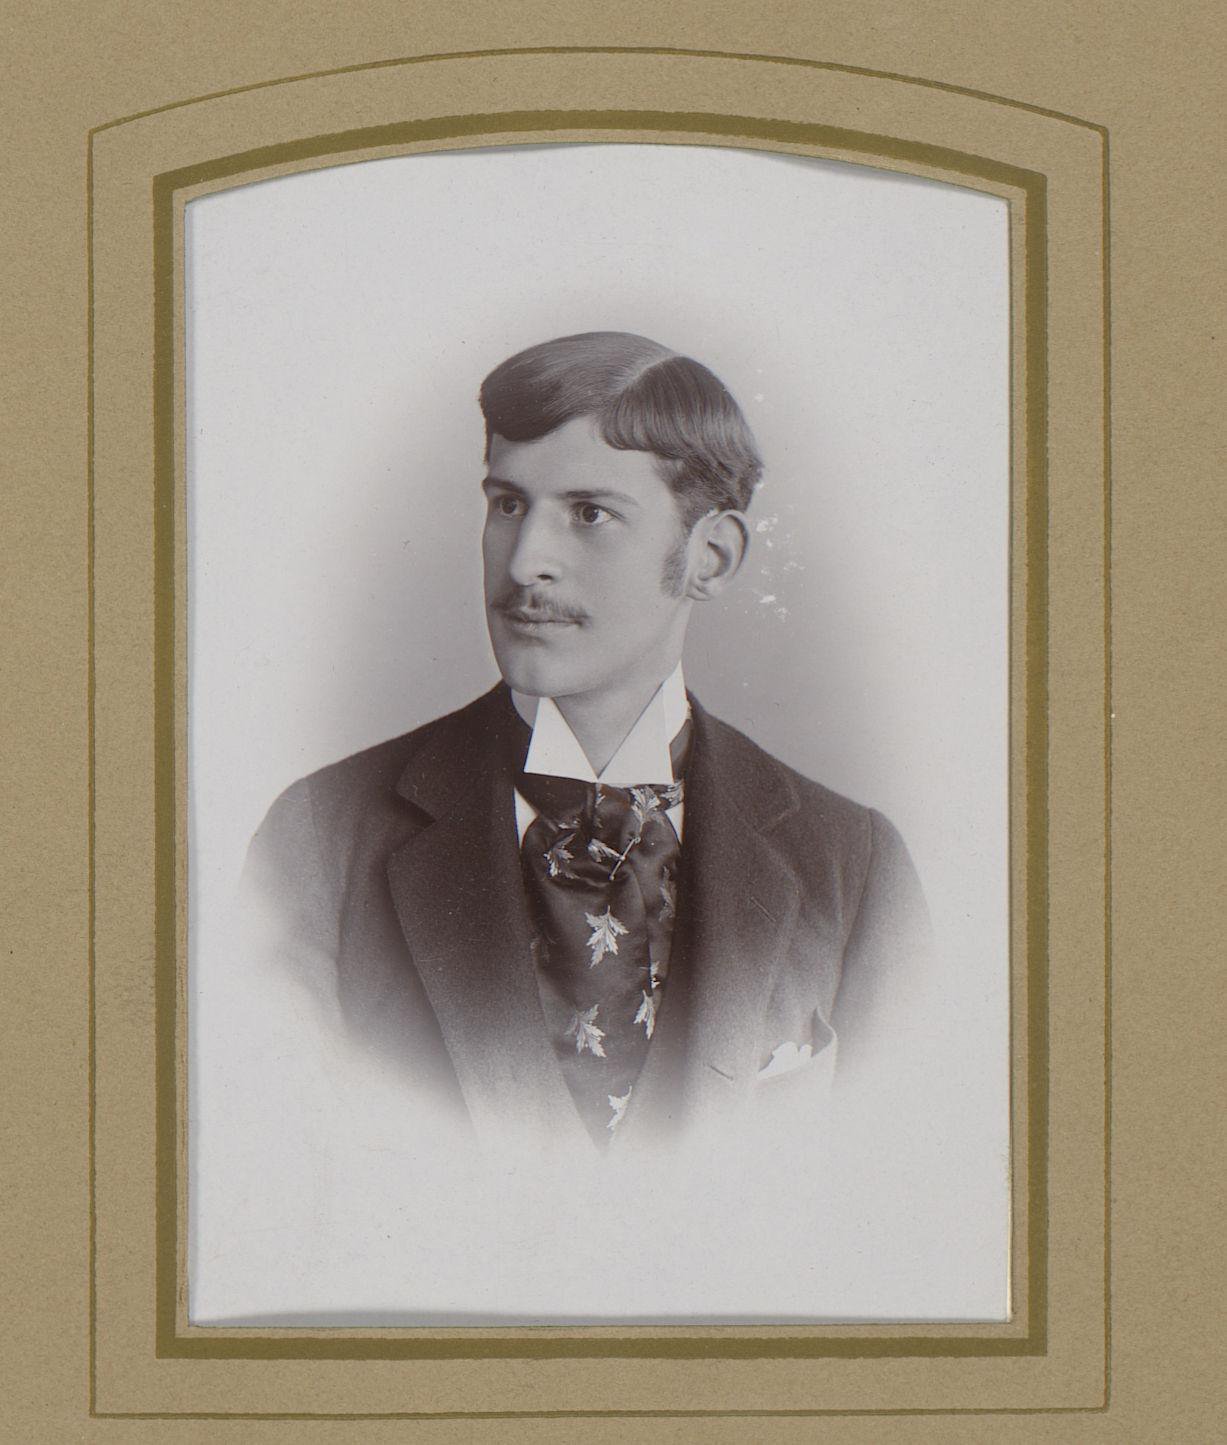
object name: photograph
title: Portret van een man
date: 1894-1907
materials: cardboard, photographic support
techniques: collodion silver print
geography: netherlands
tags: historical persons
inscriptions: inscription: ‘Koene & Büttinghausen/ Amsterdam/ Heerengracht 150./ Batavia.’